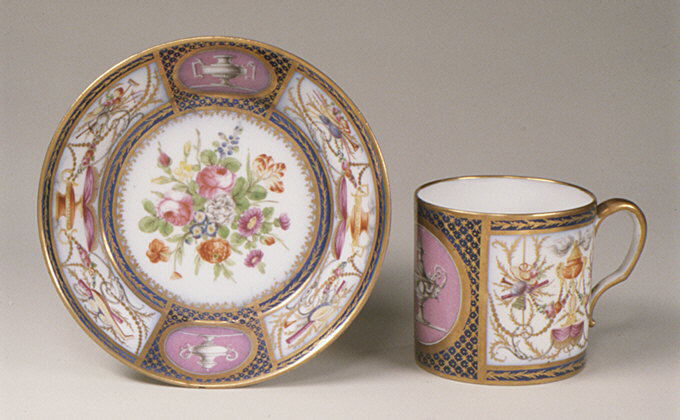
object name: cup and saucer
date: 1790-1800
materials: hard paste porcelain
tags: flowers